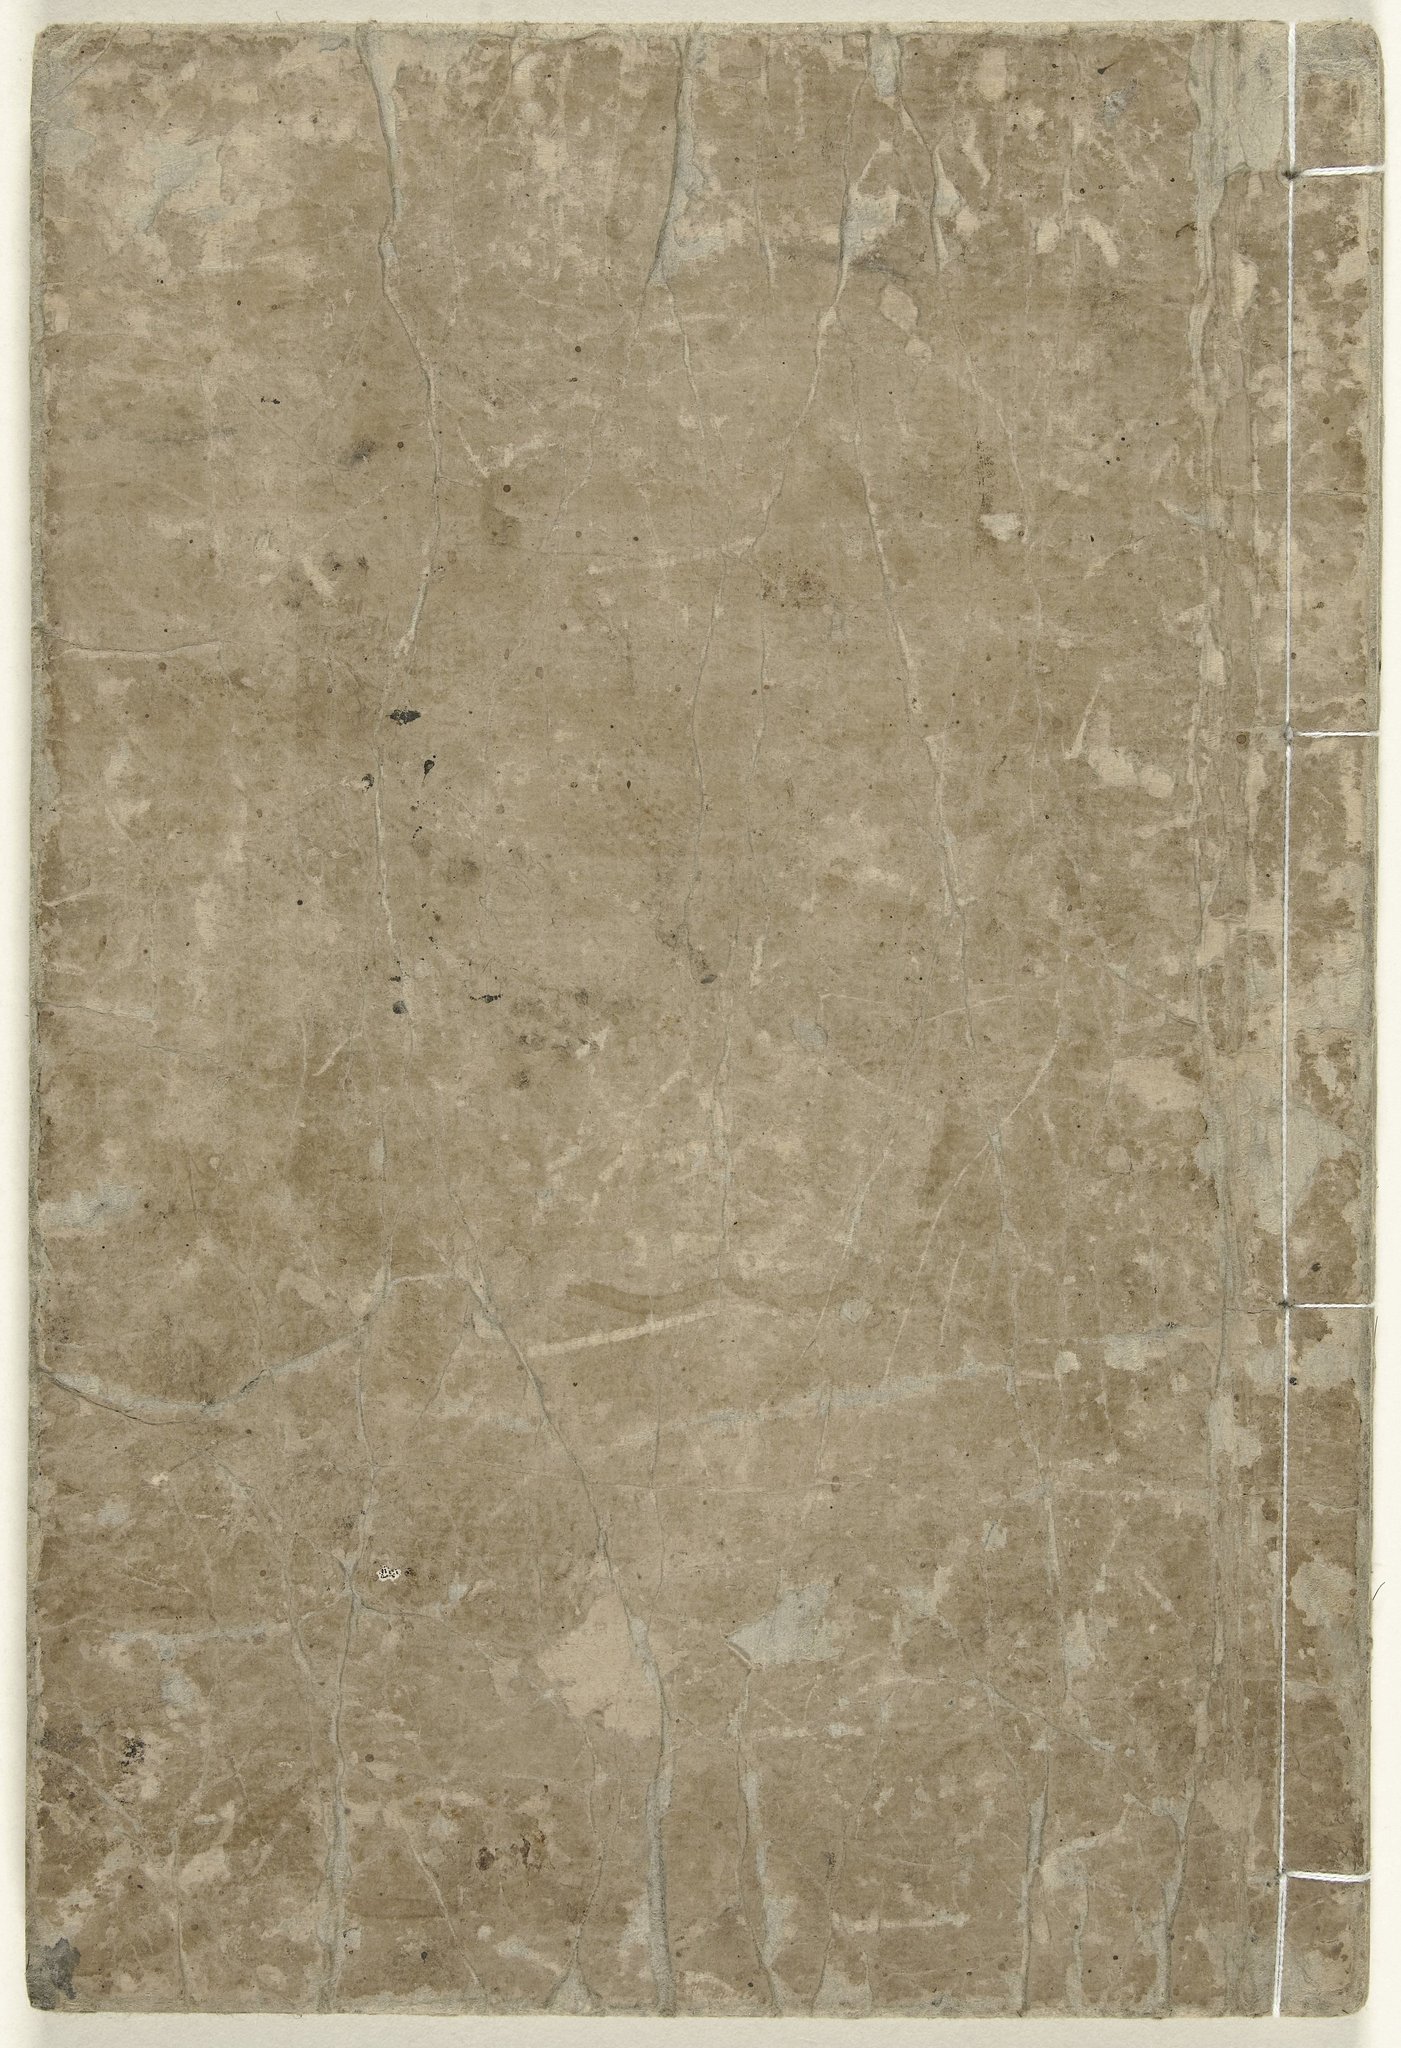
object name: book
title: Paars gras, deel twee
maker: yashima gakutei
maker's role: print maker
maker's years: 1786-1868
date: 1827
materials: paper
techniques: blind stamped, woodcut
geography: japan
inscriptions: collector's mark: Lugt 2228